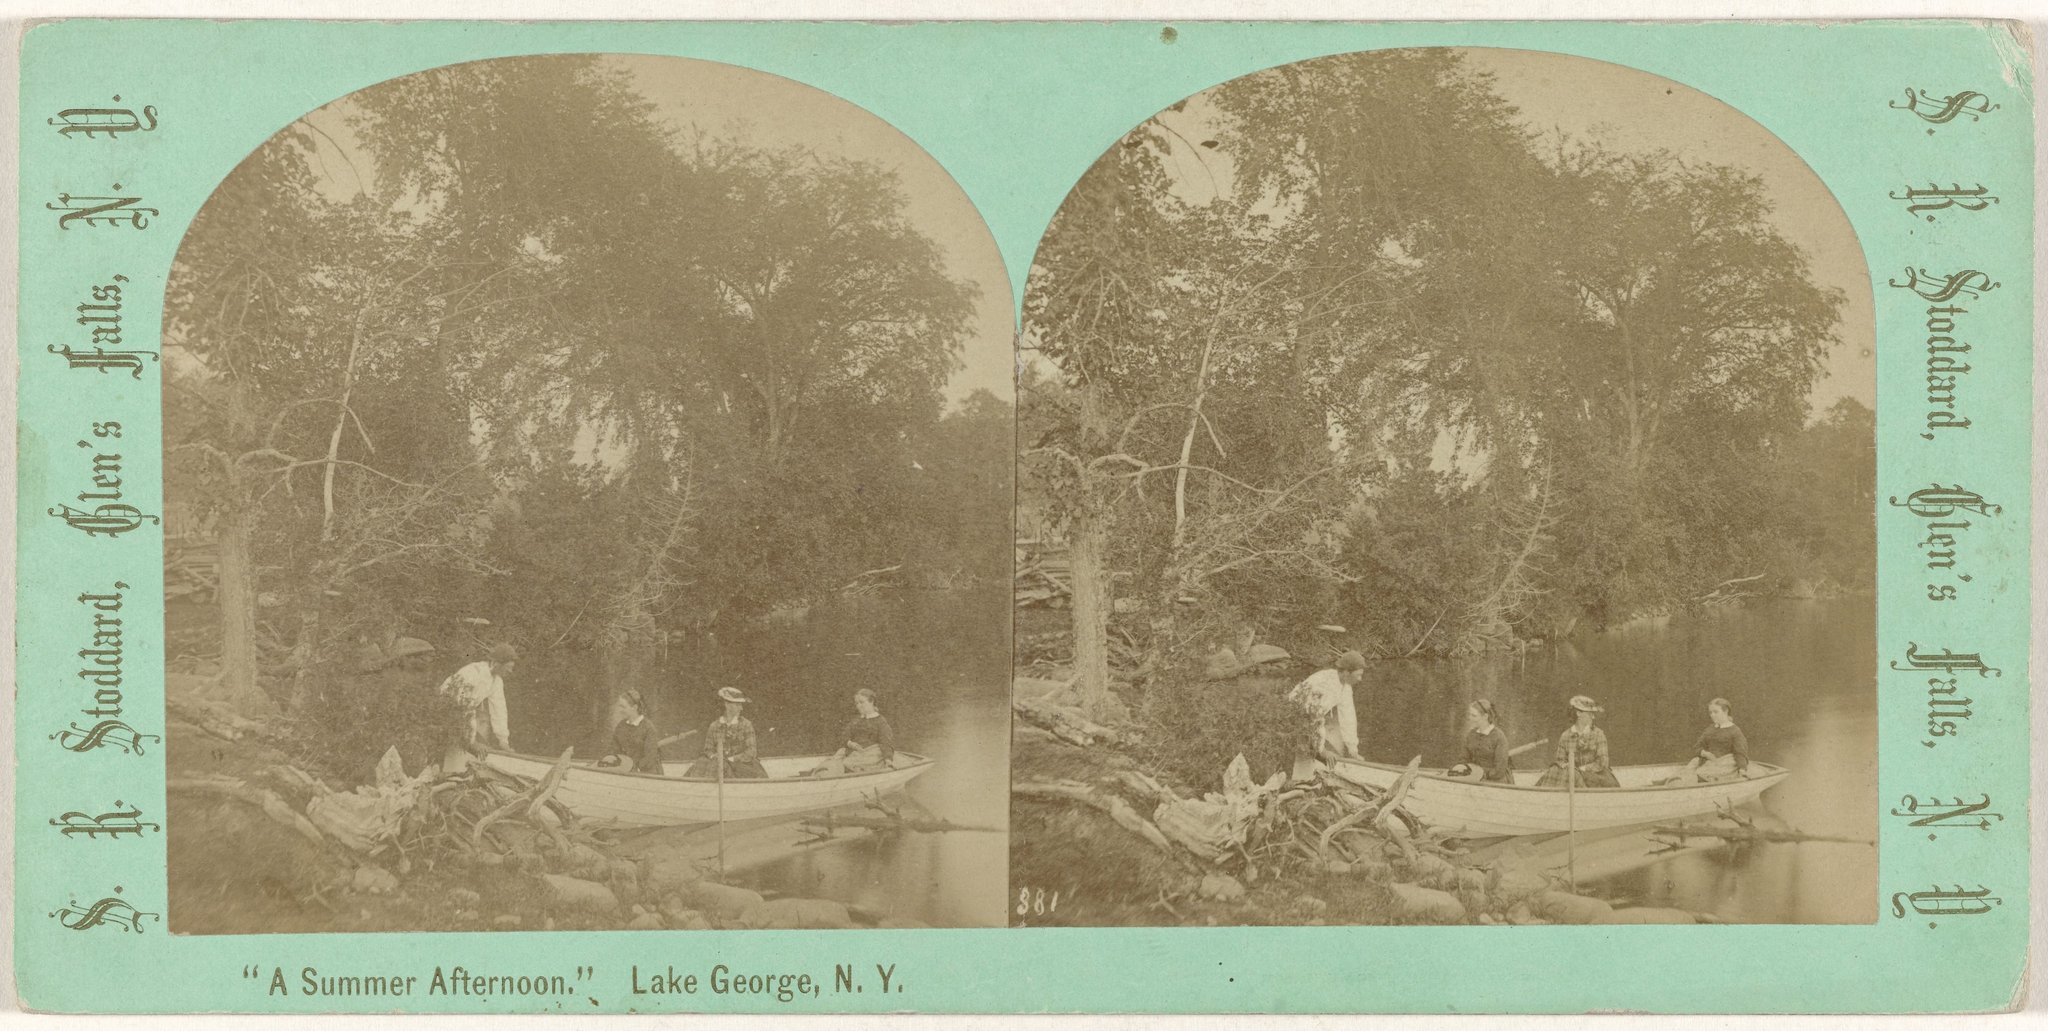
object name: stereograph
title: A Summer Afternoon, Lake George N.Y.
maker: seneca ray stoddard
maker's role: fotograaf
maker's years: 1843-1917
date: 1868-1873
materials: cardboard, paper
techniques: albumen print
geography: lake george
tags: rowing-boat, canoe, etc., lake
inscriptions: number: ‘381’